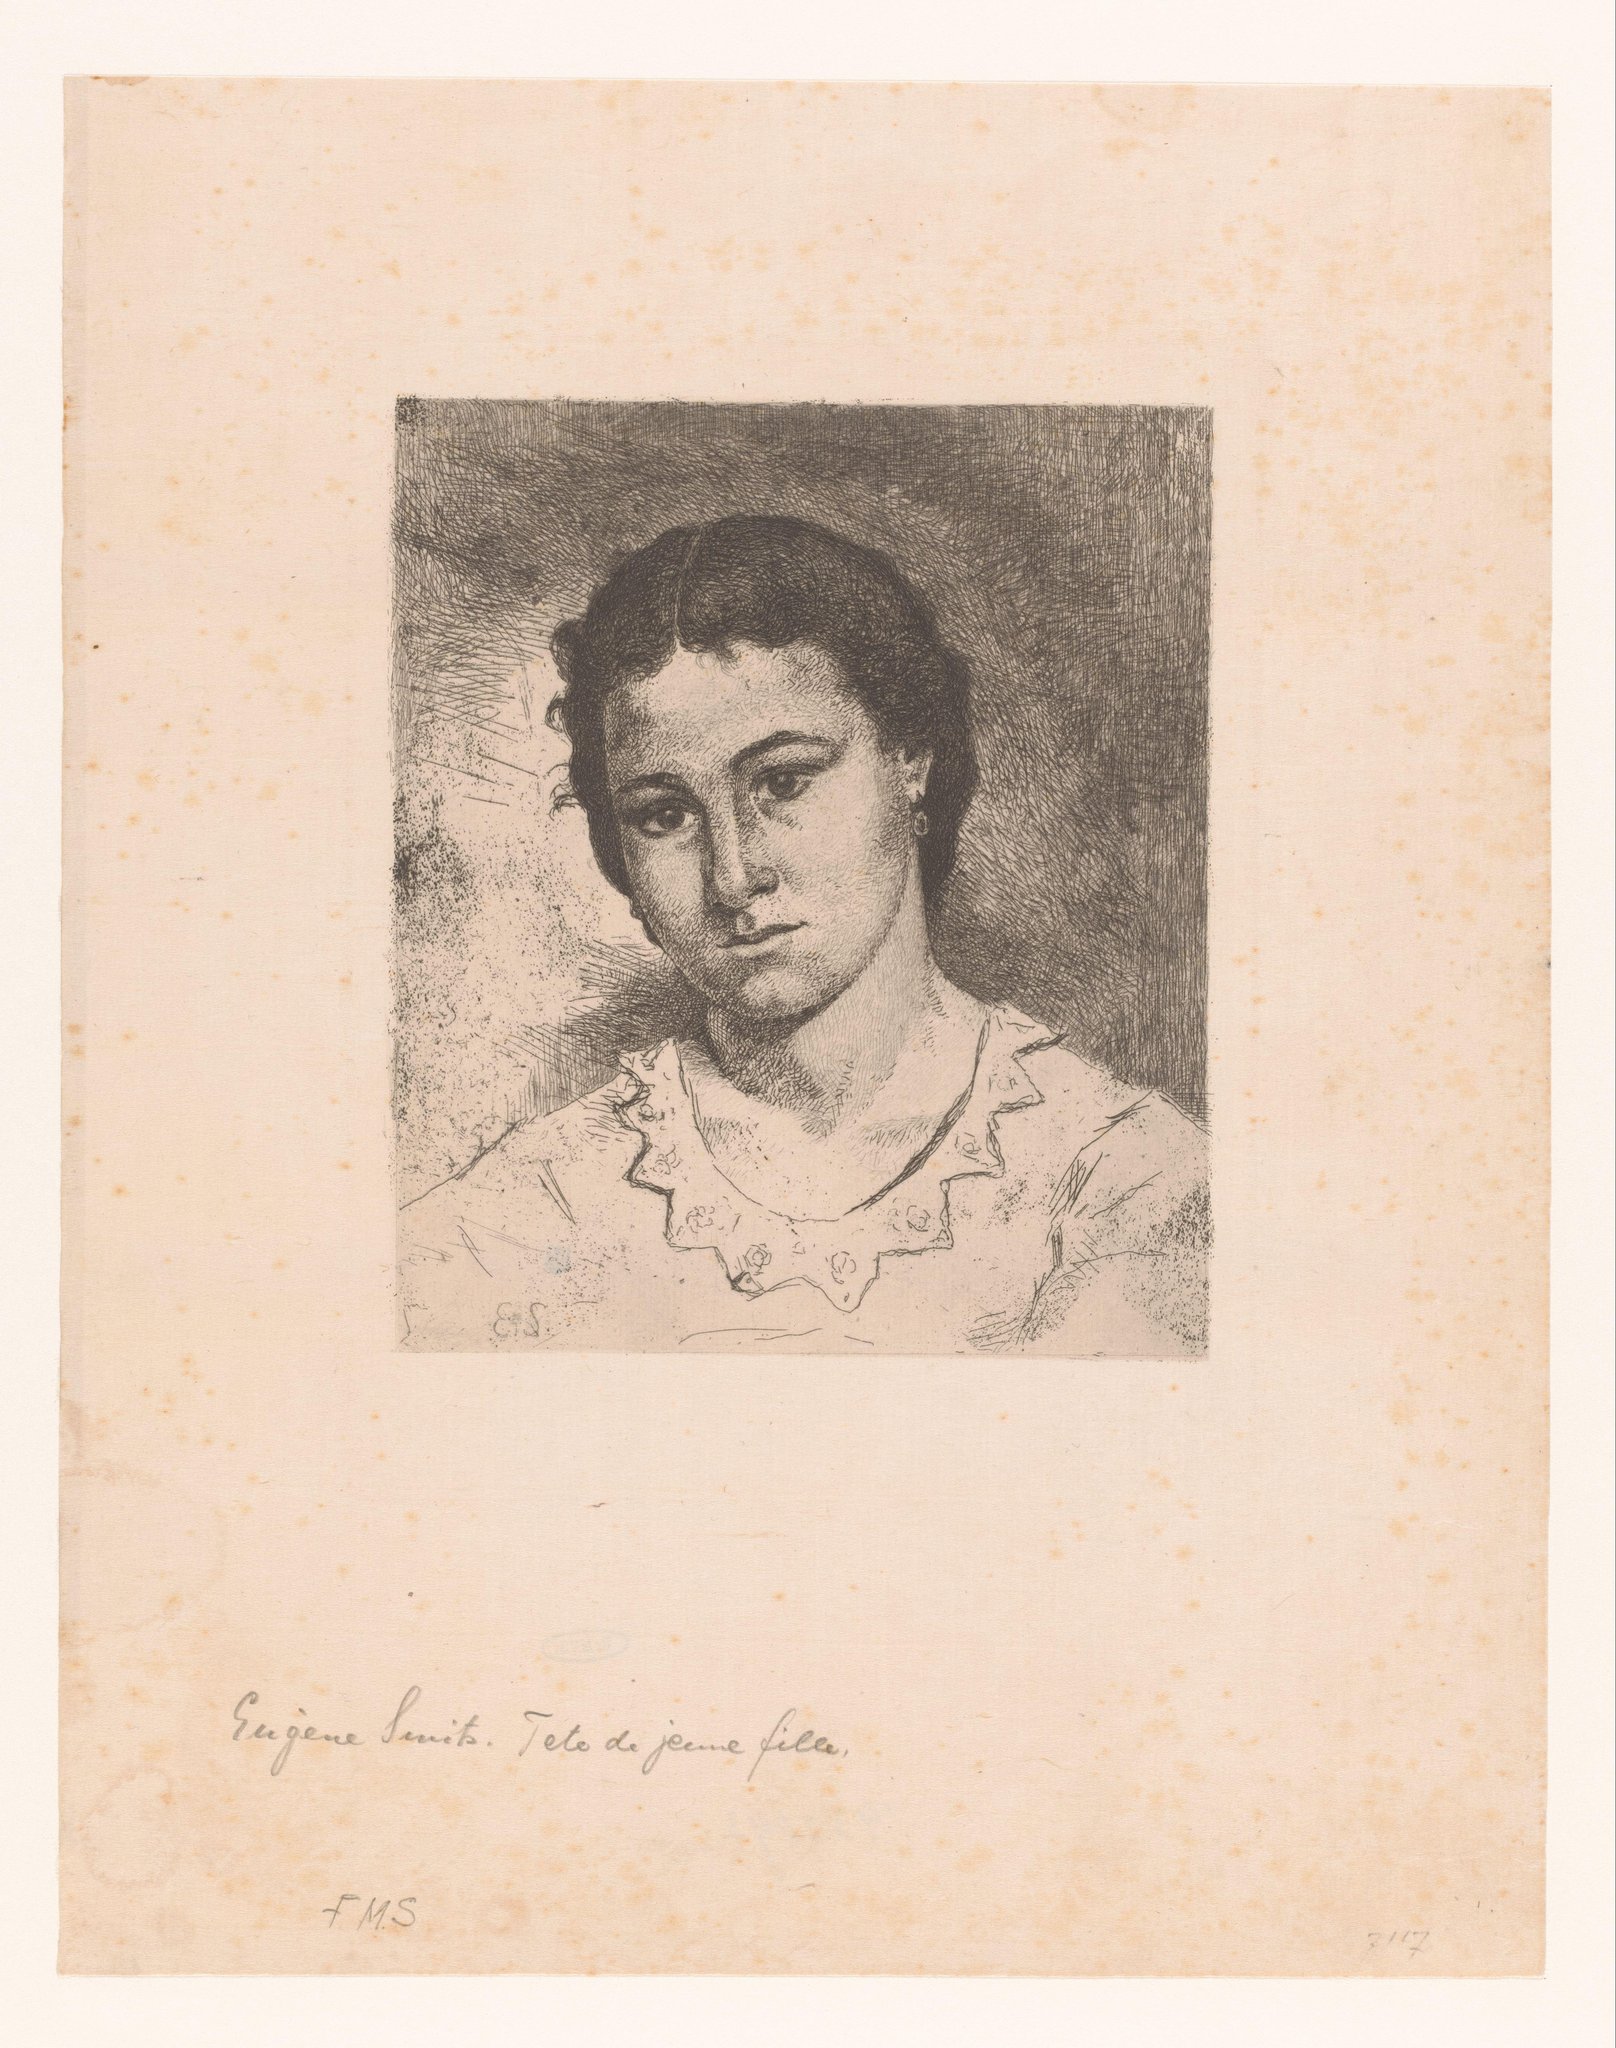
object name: print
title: Portret van een onbekende jonge vrouw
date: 1811-1875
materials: paper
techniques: drypoint, etching, intaglio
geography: brussels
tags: anonymous historical person portrayed alone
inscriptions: collector's mark: Lugt 2760, collector's mark: Lugt 2228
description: Prent uit de novemberaflevering 'Album d'eaux-fortes originales et inédites'.